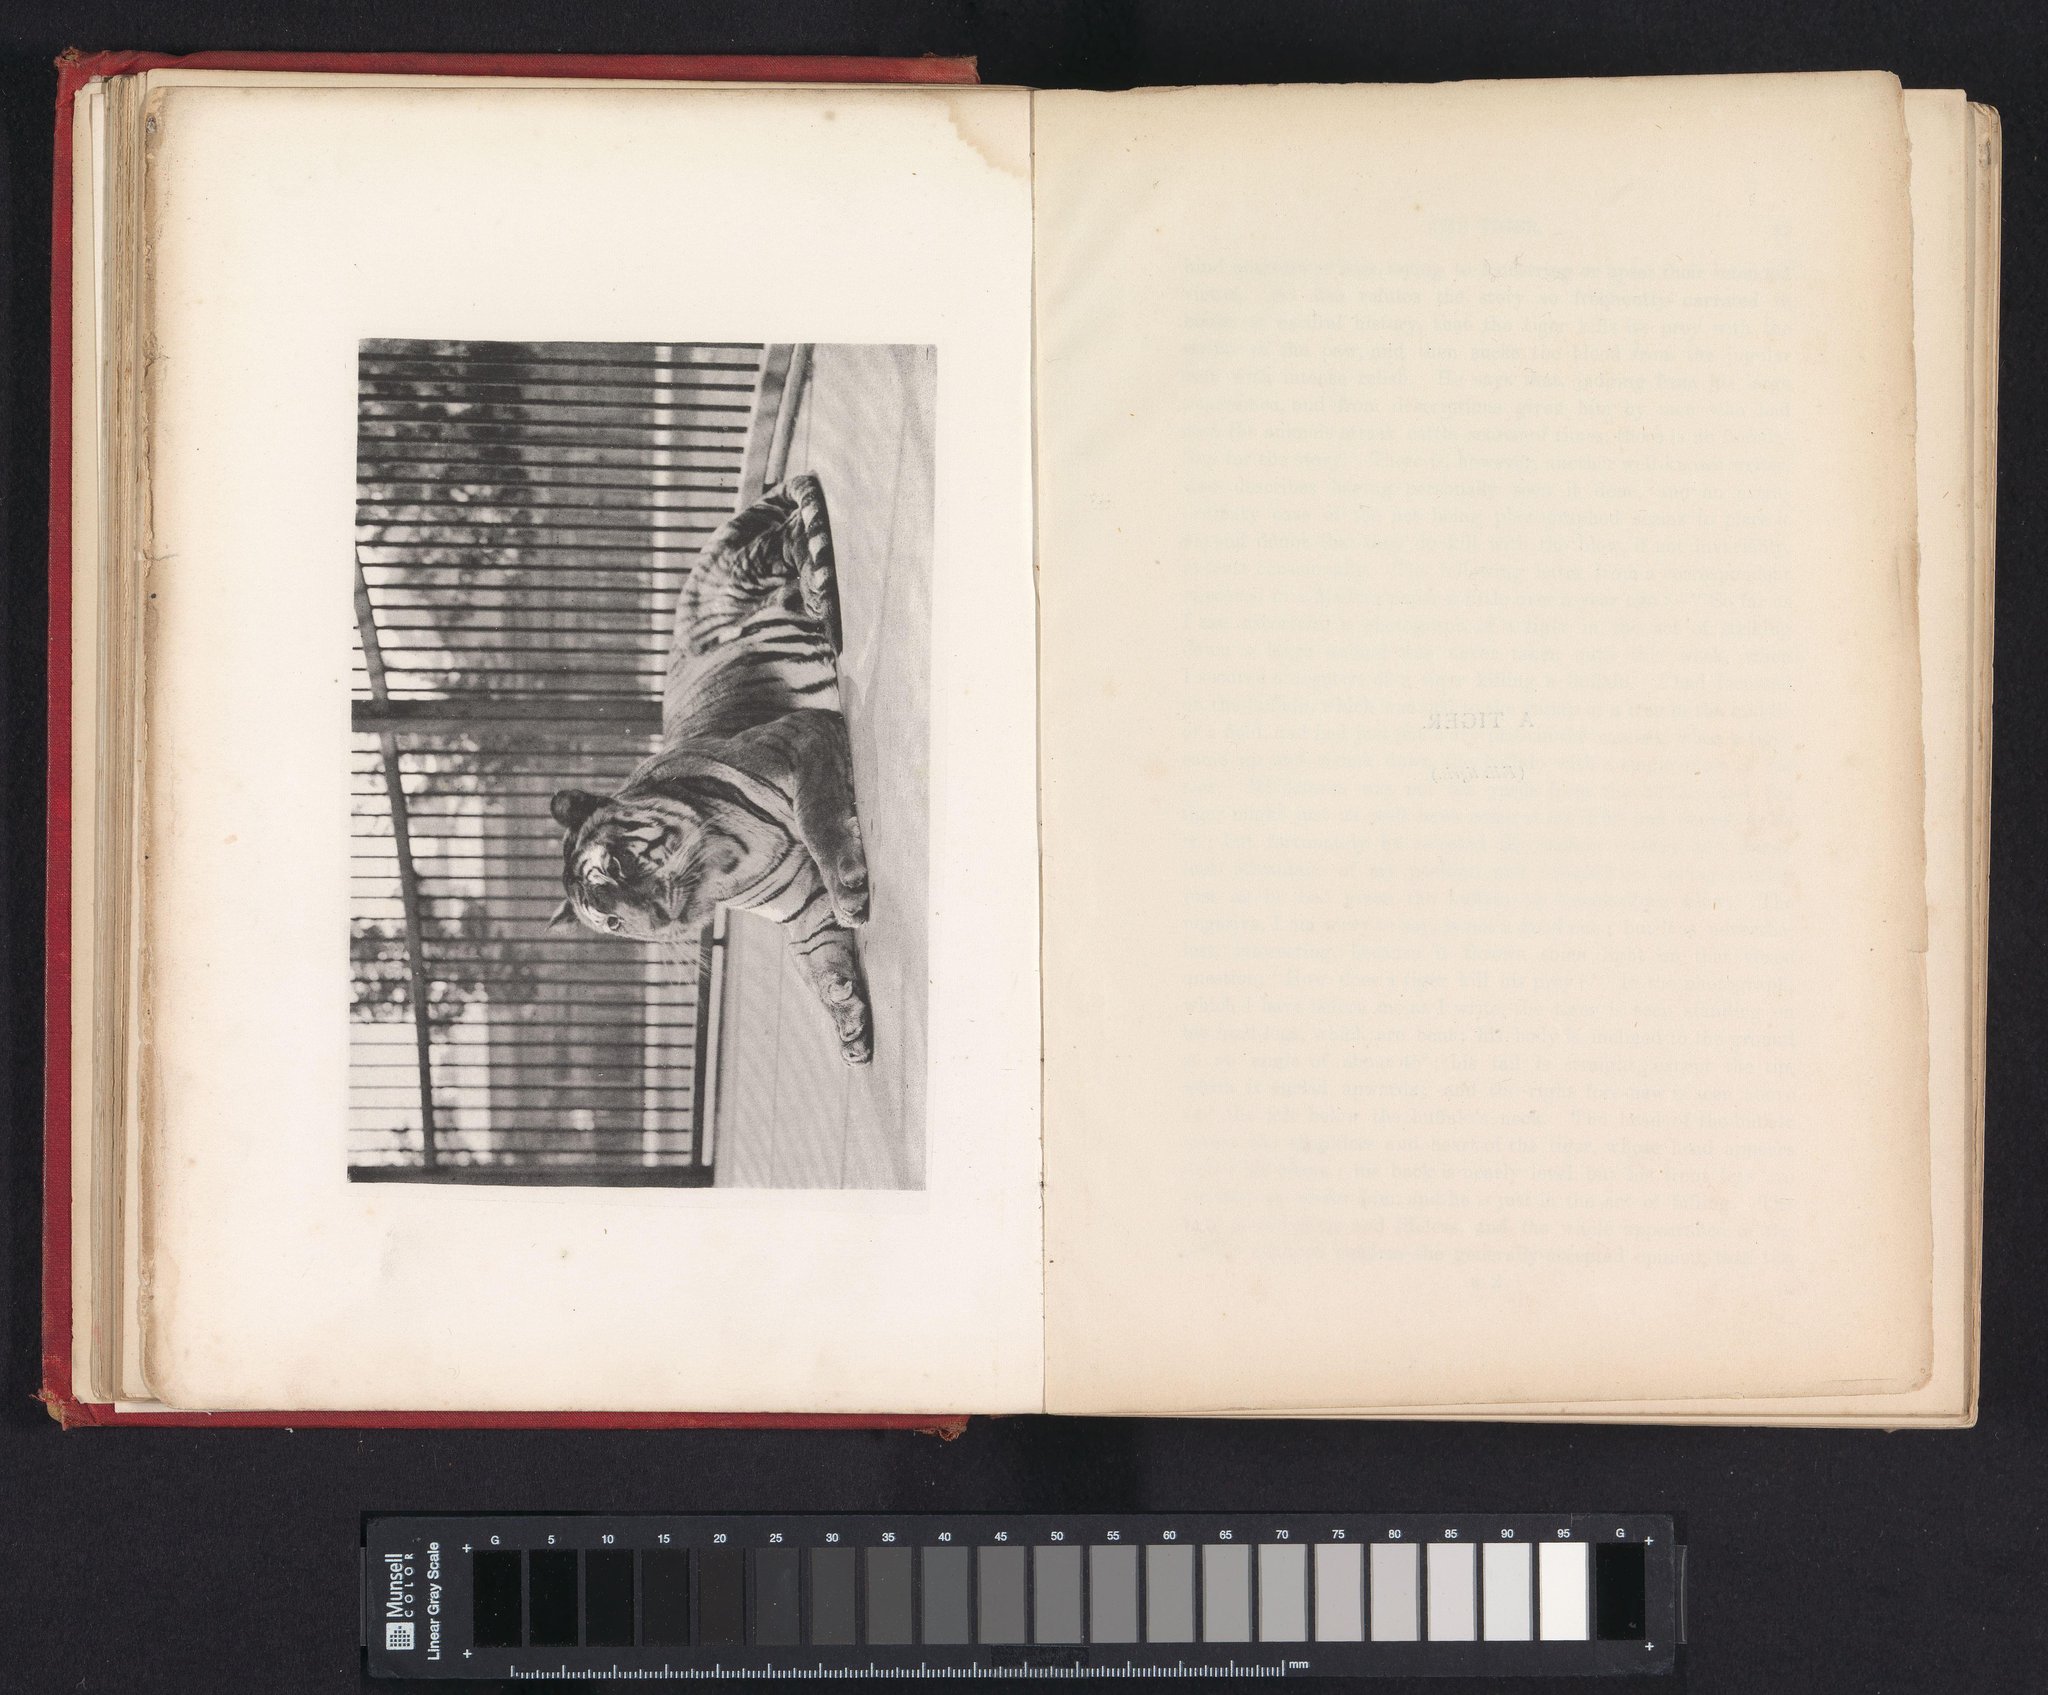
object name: photomechanical print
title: A tiger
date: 1876-1886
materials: paper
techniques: photograph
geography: paris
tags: beasts of prey, predatory animals: tiger